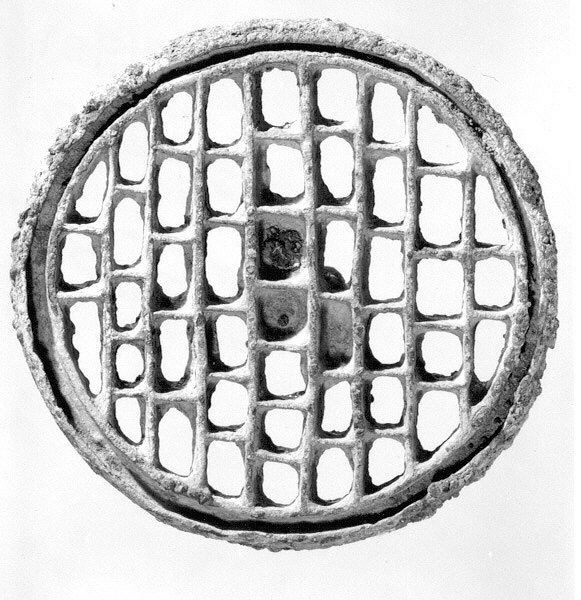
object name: stamp seal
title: Compartmented stamp seal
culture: bactria-margiana archaeological complex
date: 2333-1668 BCE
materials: copper alloy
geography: bactria-margiana